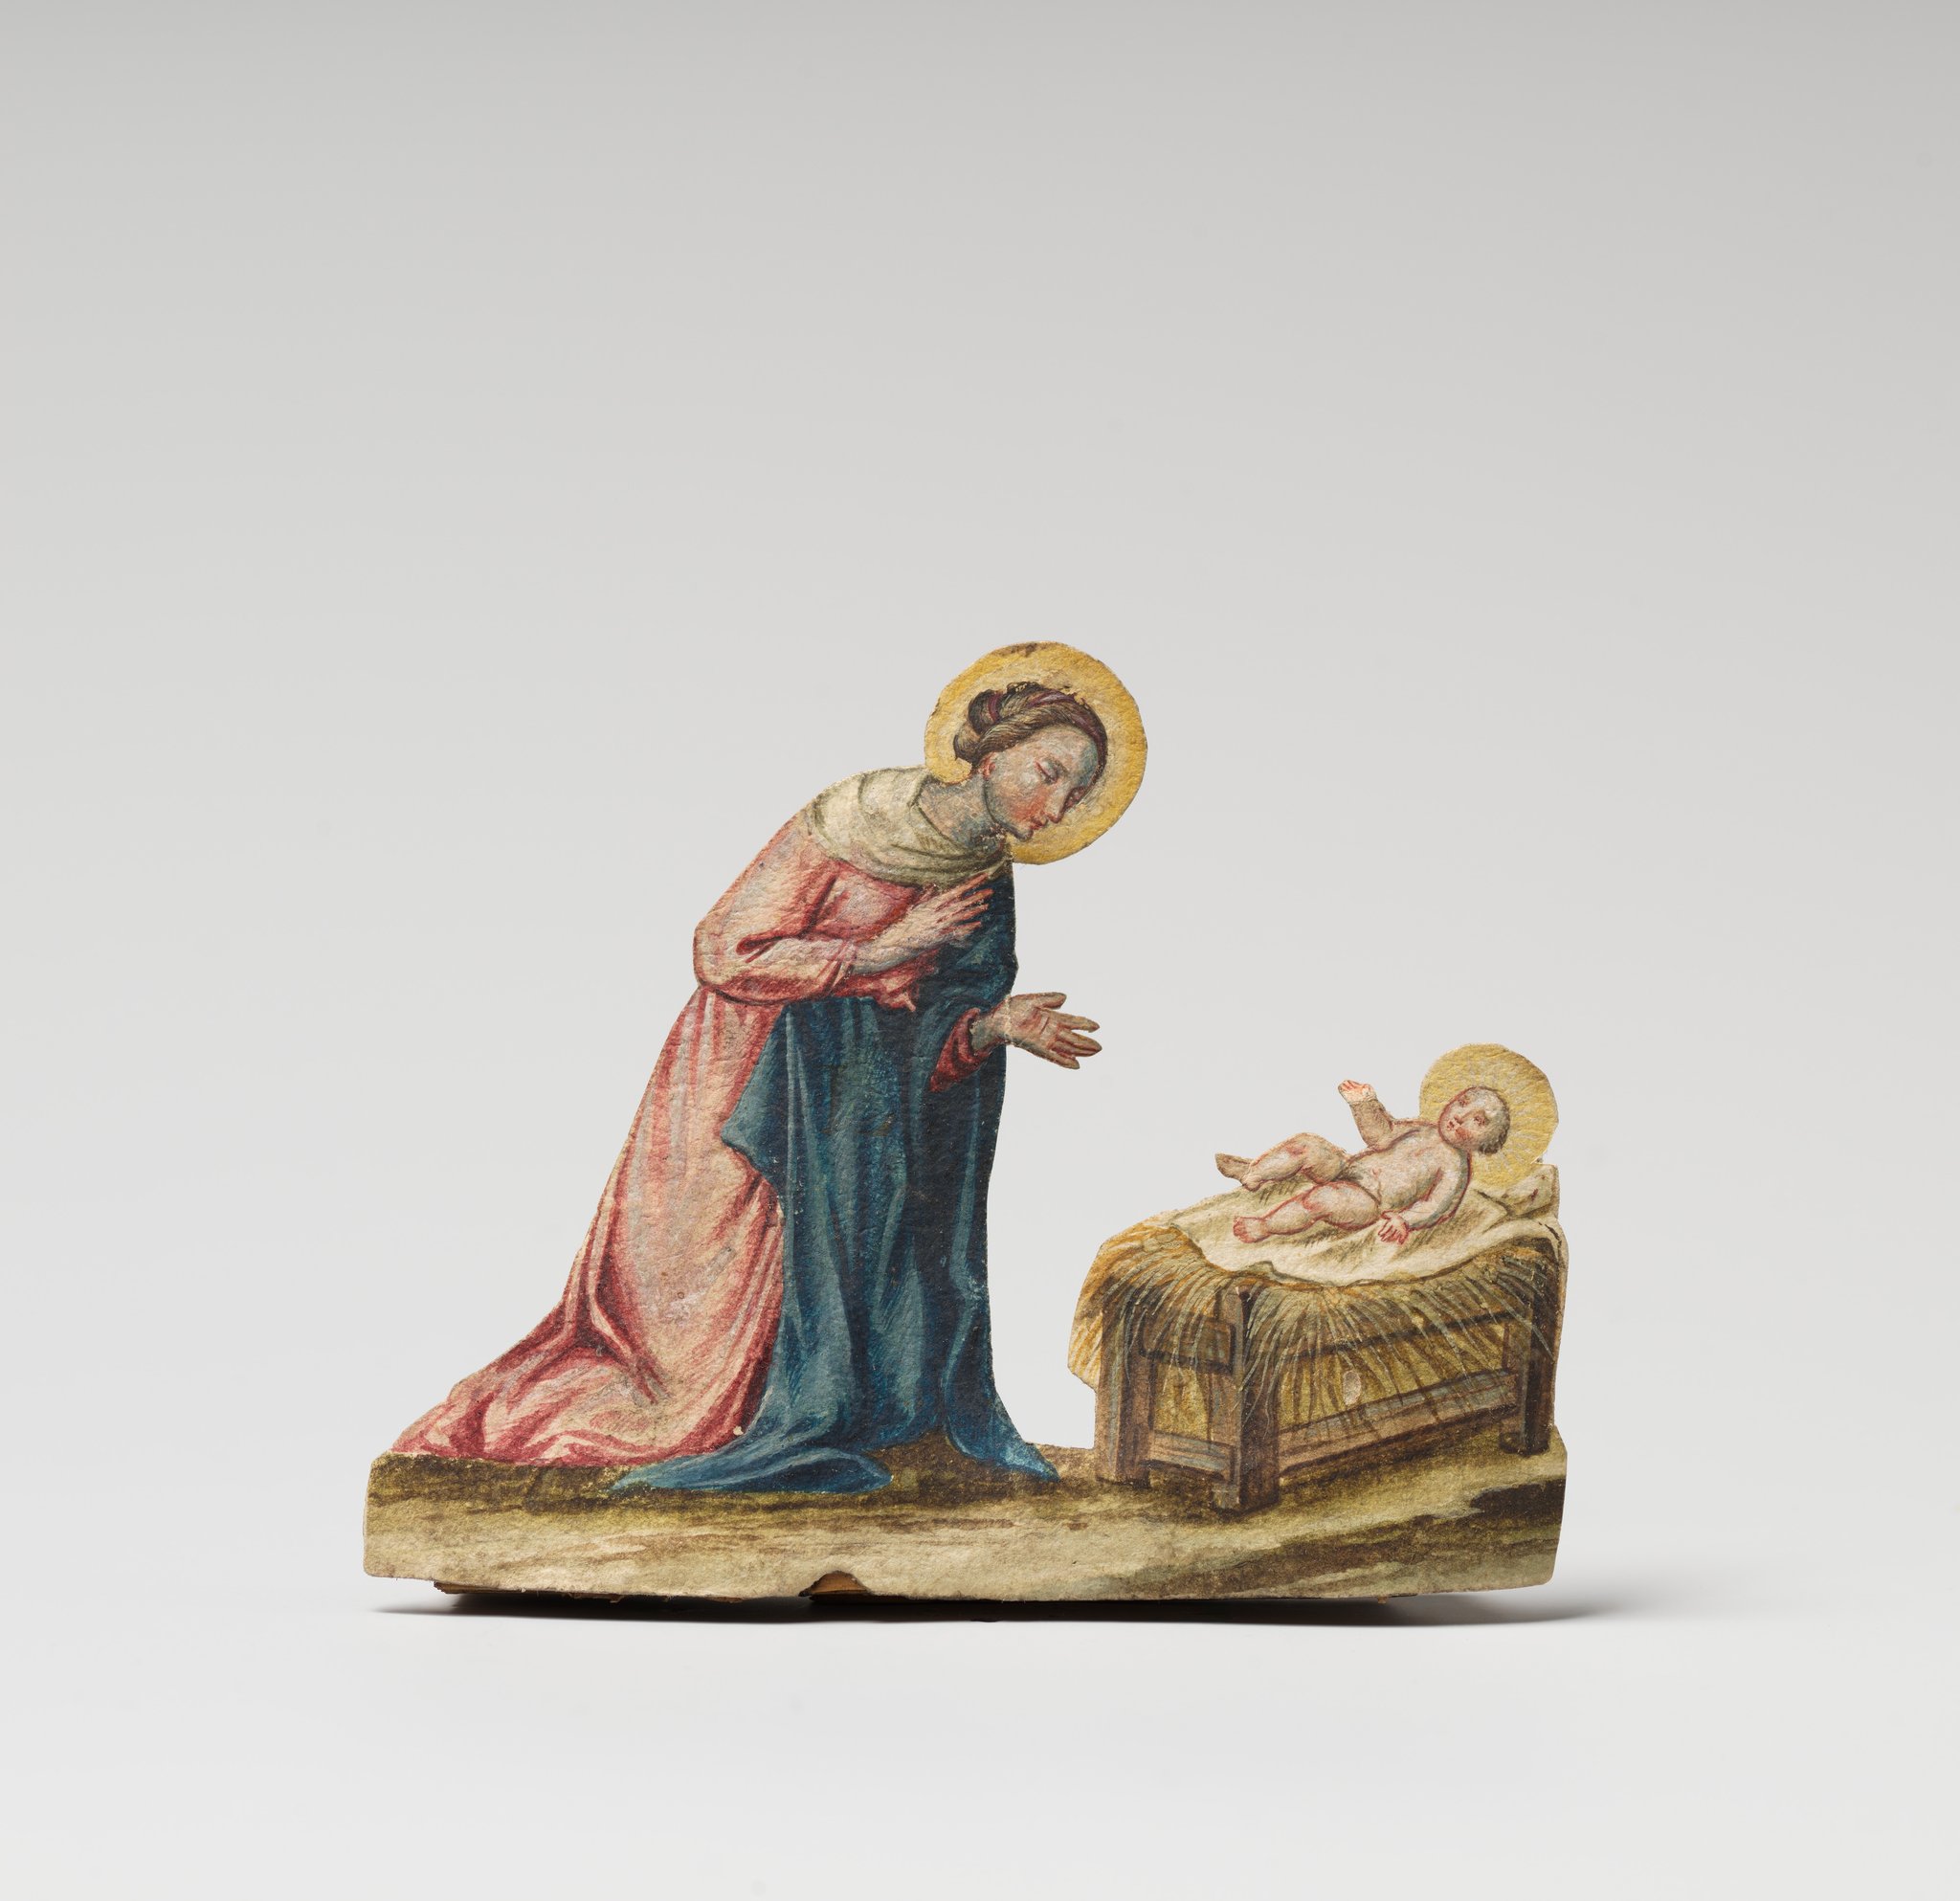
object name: figure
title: Virgin Mary with Christ in a Manger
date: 1701-1800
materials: gouache, paper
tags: madonna and child